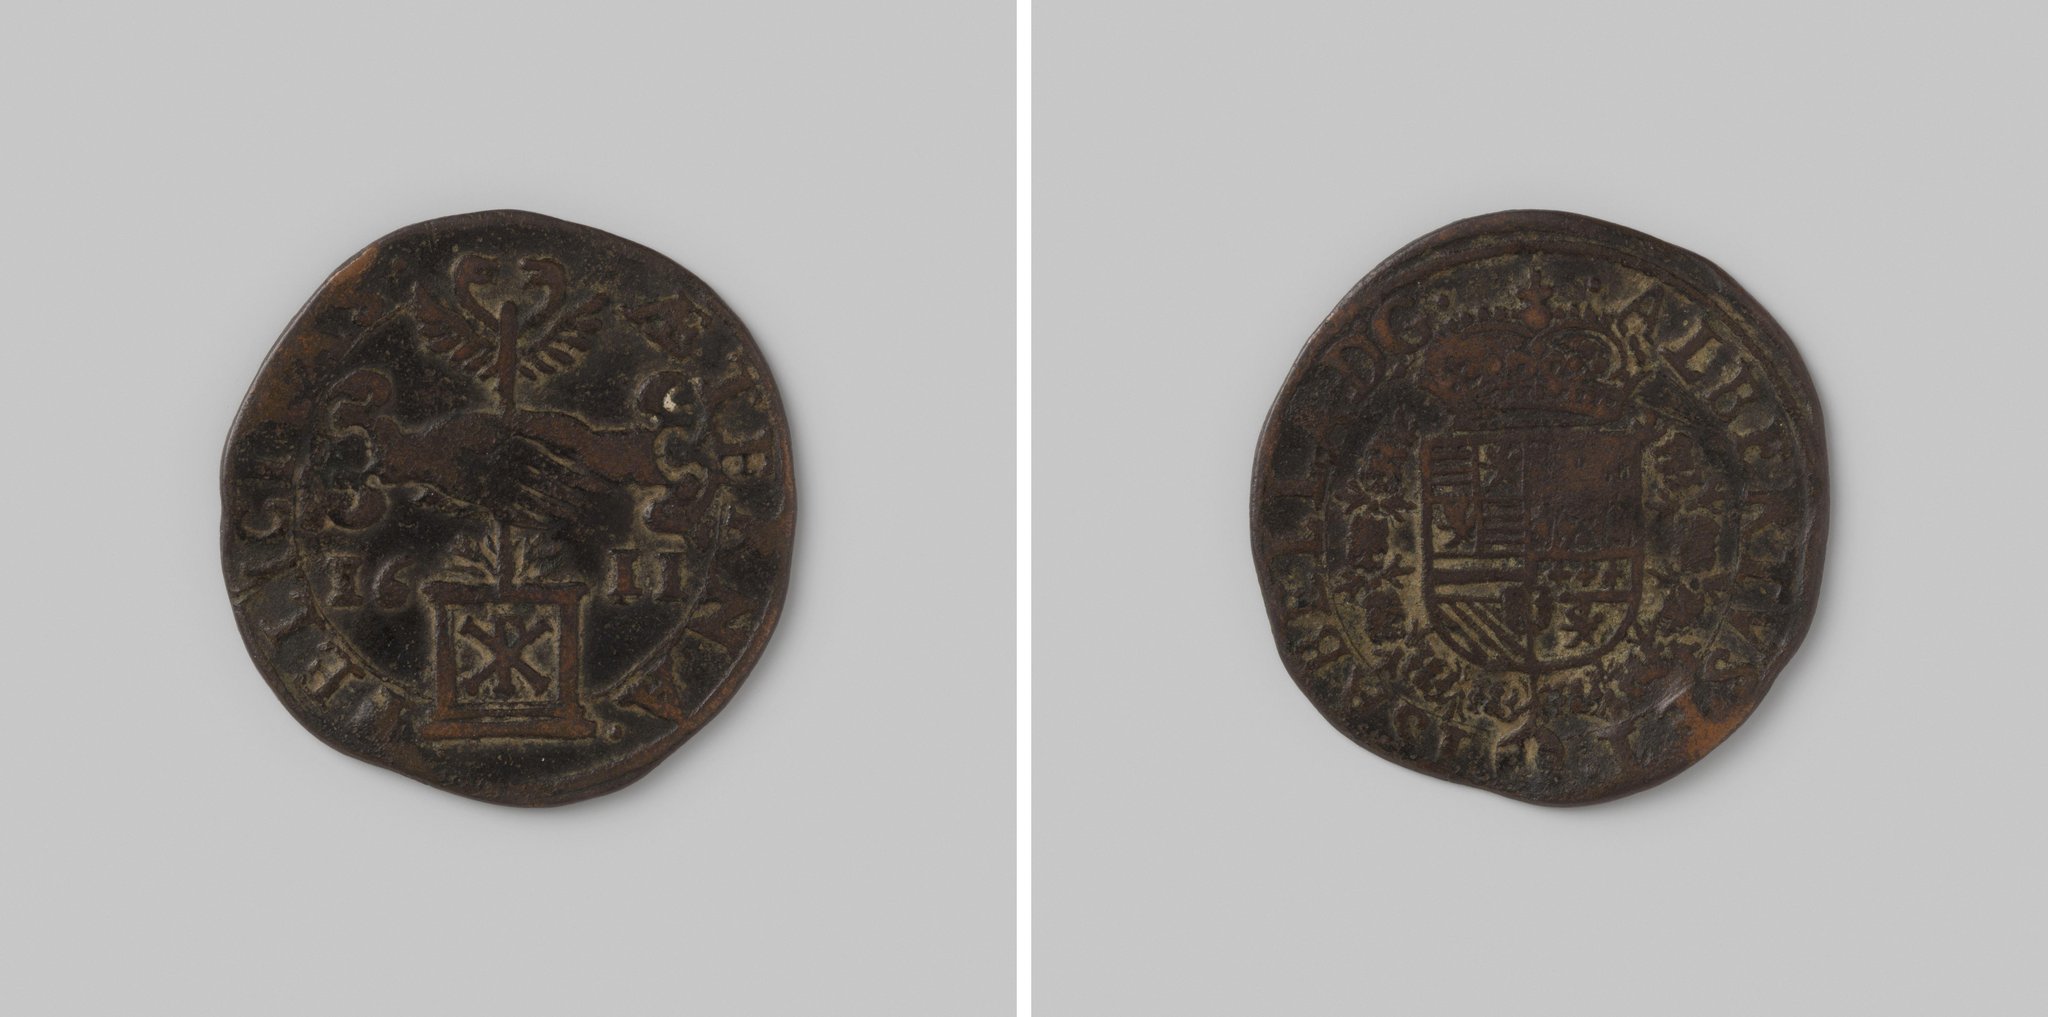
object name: history medal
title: Rekenpenning op de voorspoedige vooruitzichten van een bestand 1611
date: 1611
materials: copper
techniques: striking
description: Koperen penning, op de voorzijde een altaar waarboven twee ineengeslagen handen voor een mercuriusstaf, met jaartal in het veld en omschrift, op de keerzijde het gekroonde Spaanse wapenschild omhangen met de keten van het Gulden Vlies, met omschrift.